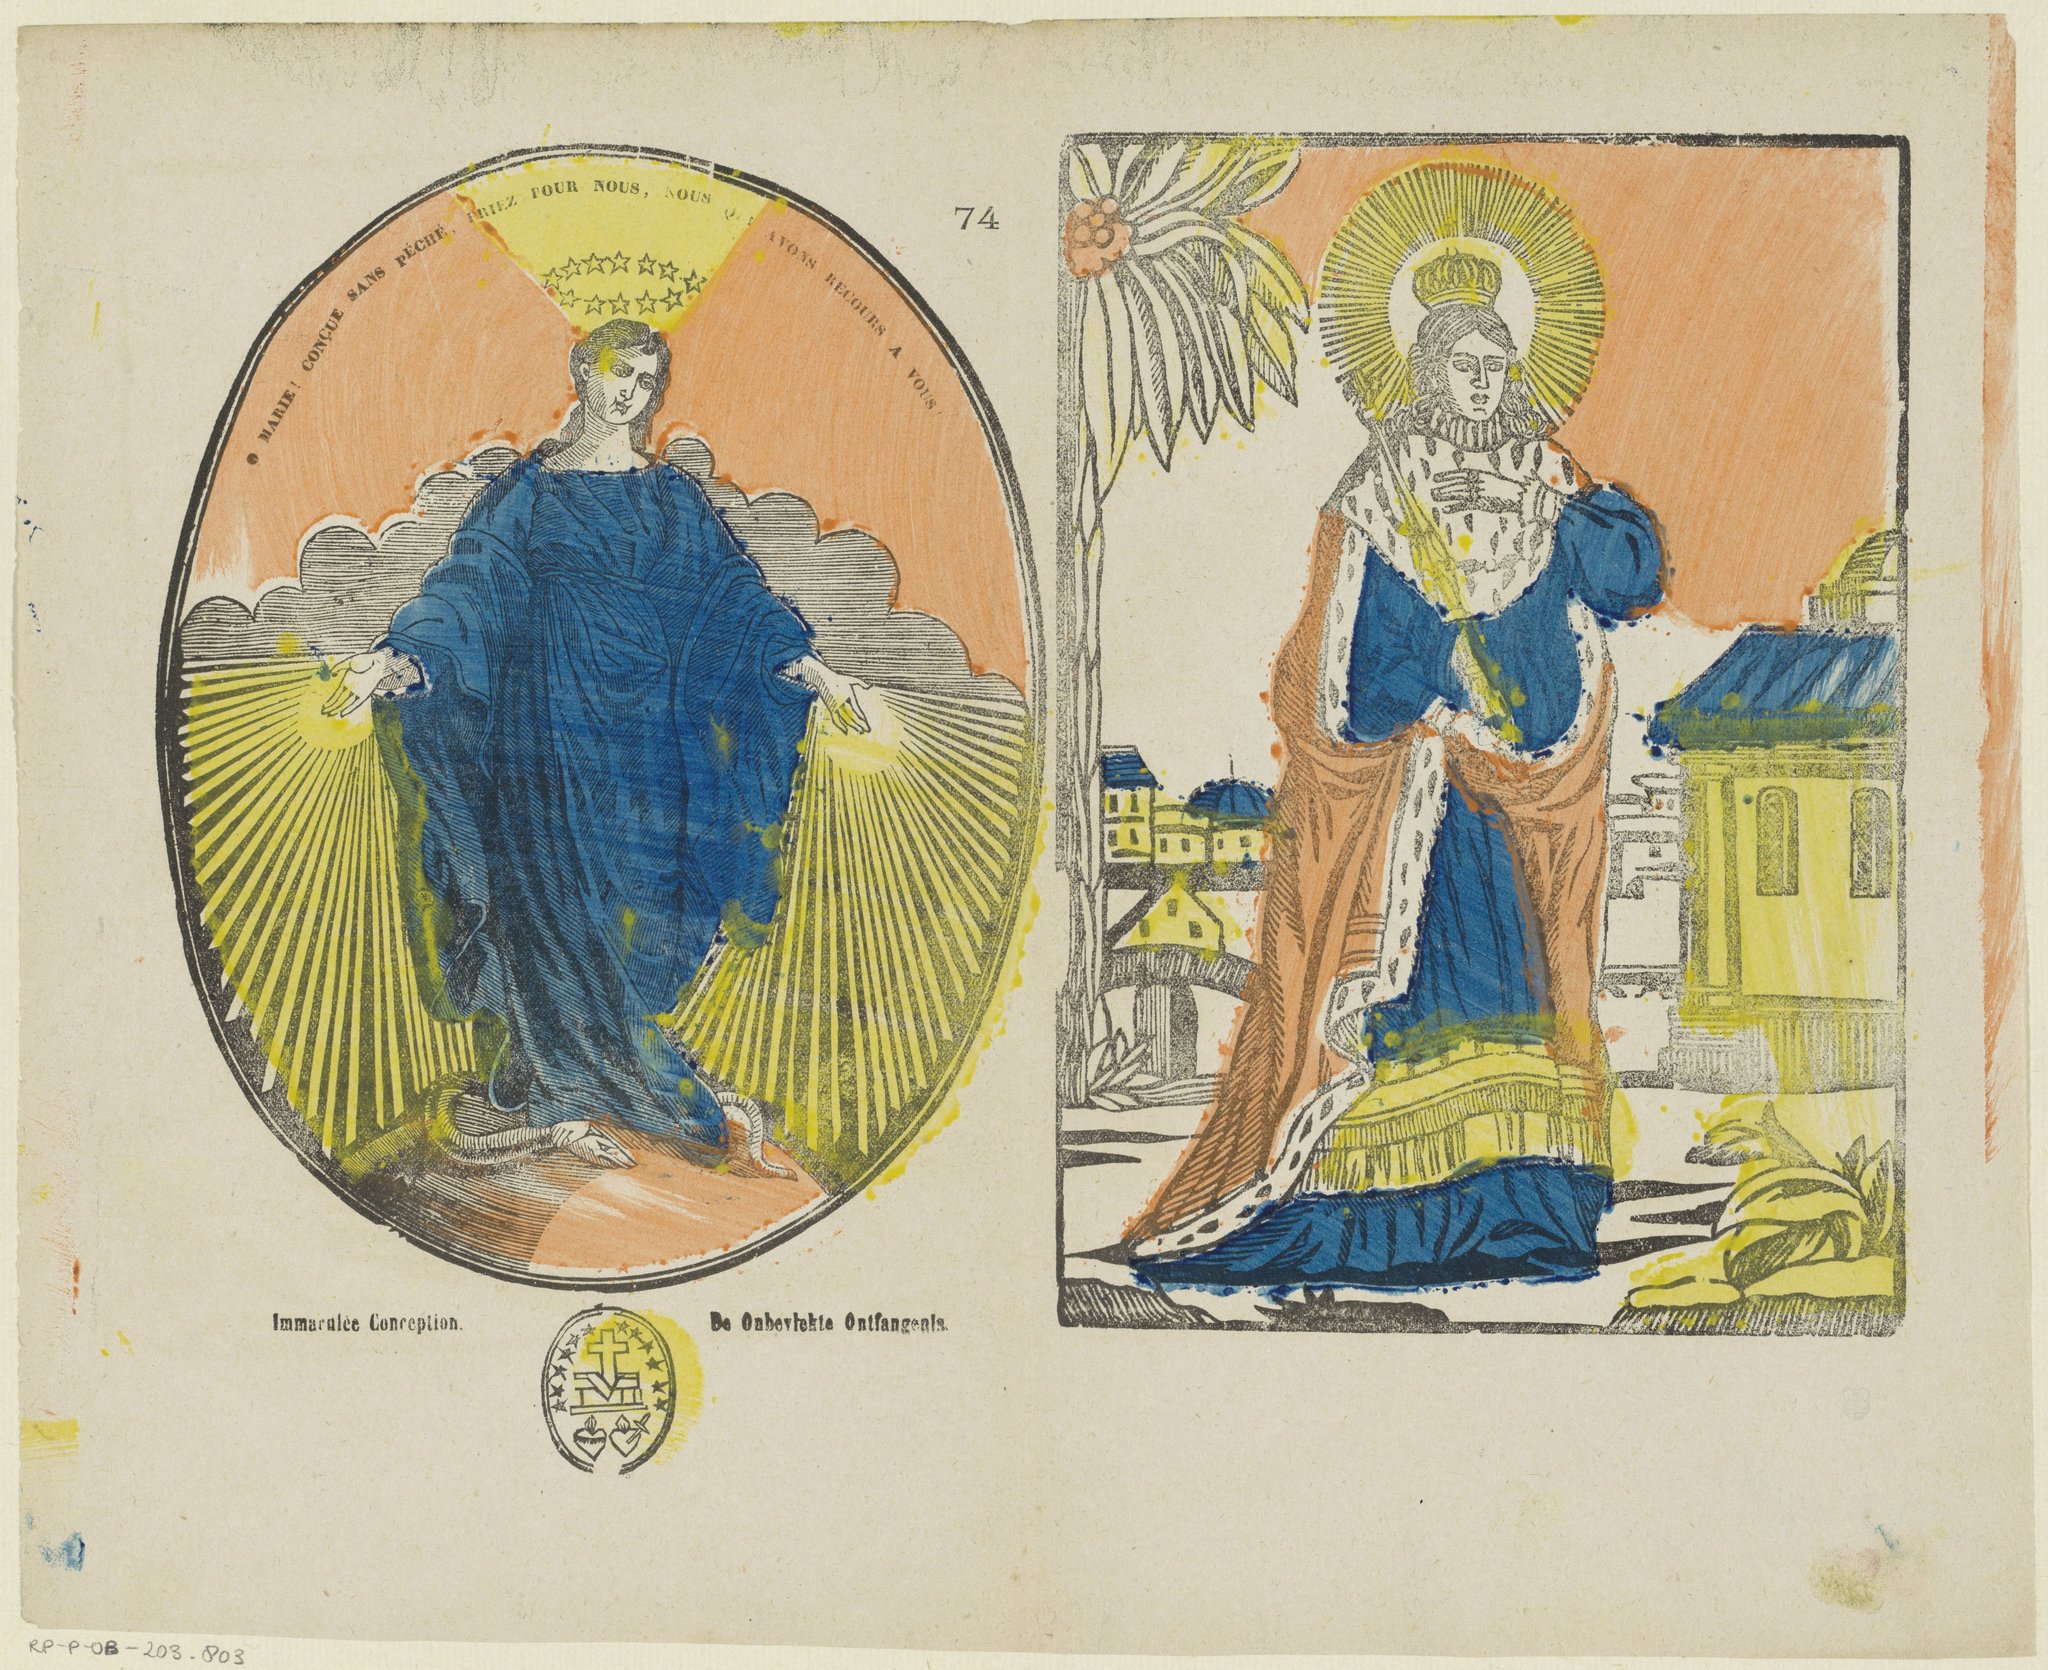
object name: popular print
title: Immaculée conception / De onbevlekte ontfangenis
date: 1827-1894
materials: paper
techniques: colour, letterpress printing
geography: schaarbeek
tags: the wife and widow of the landgrave of thuringia, and franciscan tertiary, elisabeth of hungary; possible attributes: beggar, cripple, fish, loaves, leper, model of church, pitcher, roses in lap, scald-head, three crowns, 'immaculata', 'purisima': mary, usually standing on a crescent moon, descending from heaven, exempt from original sin (sometimes trampling serpent)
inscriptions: collector's mark: Lugt 2760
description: Blad met 2 voorstellingen. Links een voorstelling van Maria, met een nimbus van sterren boven haar hoofd, staand op een slang. Rechts een voorstelling van de heilige Elisabeth van Hongarije. Genummerd midden boven: 74.